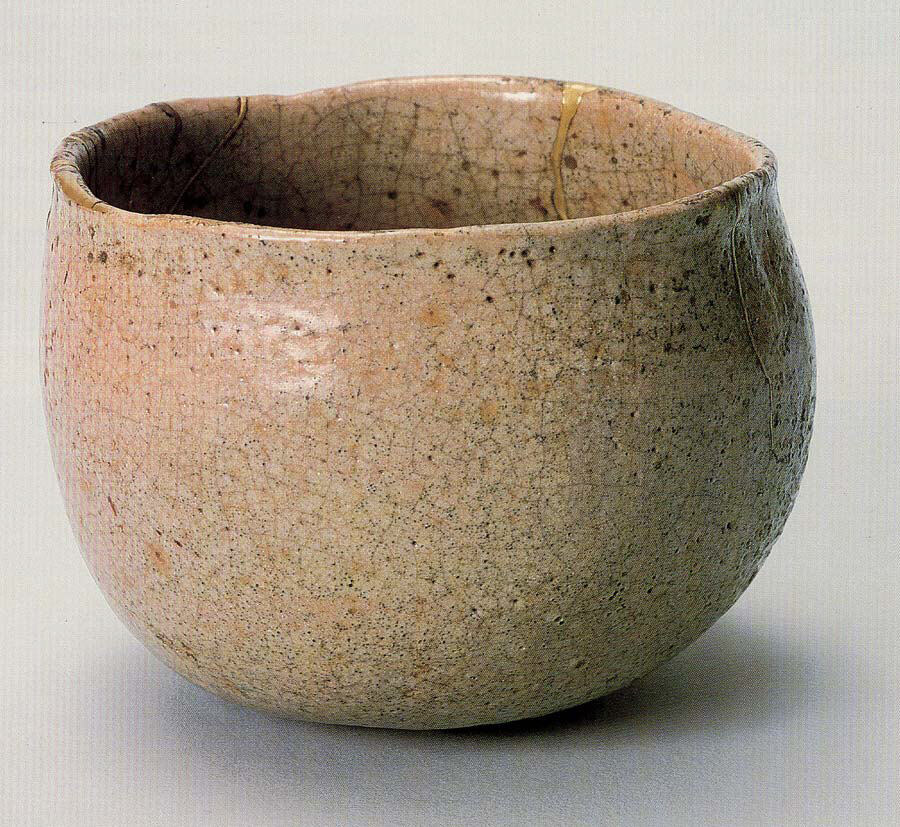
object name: teabowl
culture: japanese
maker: hon'ami kōetsu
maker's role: artist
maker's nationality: japanese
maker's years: 1558-1637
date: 1601-1700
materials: earthenware, glaze